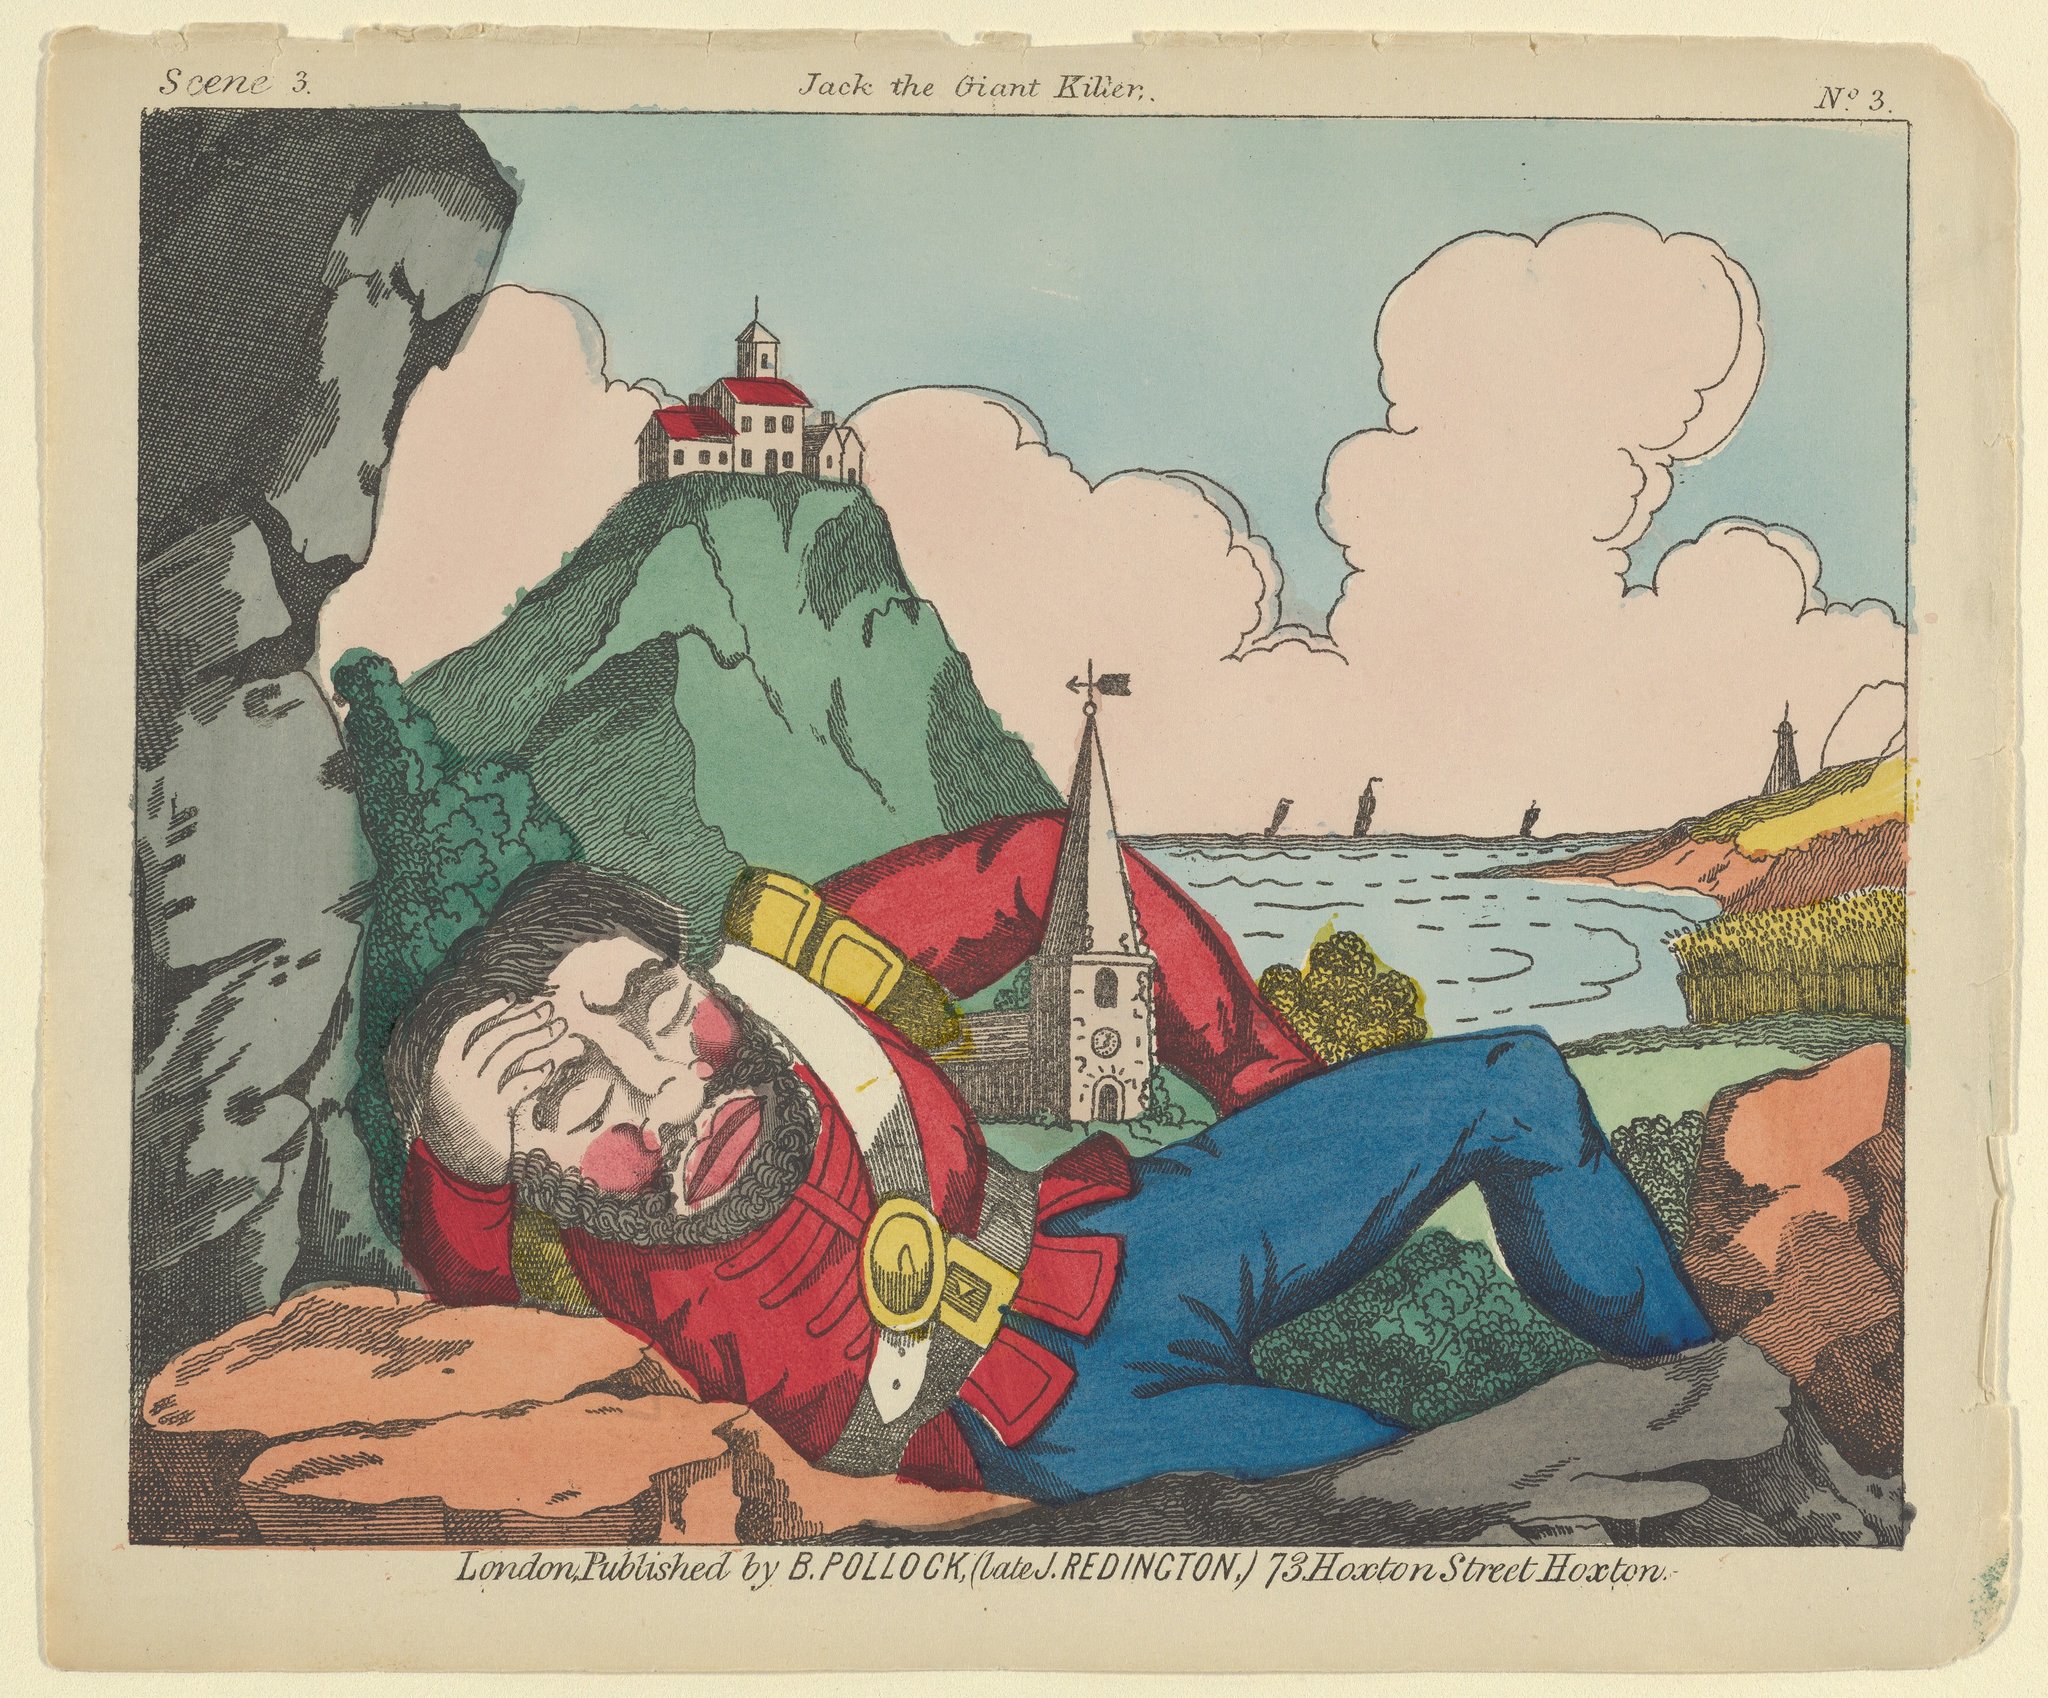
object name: print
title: Scene 3, from Jack and the Giant Killer, Scenes for a Toy Theater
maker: benjamin pollock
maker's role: publisher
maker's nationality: british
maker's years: 1857-1937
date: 1870-1890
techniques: lithograph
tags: men